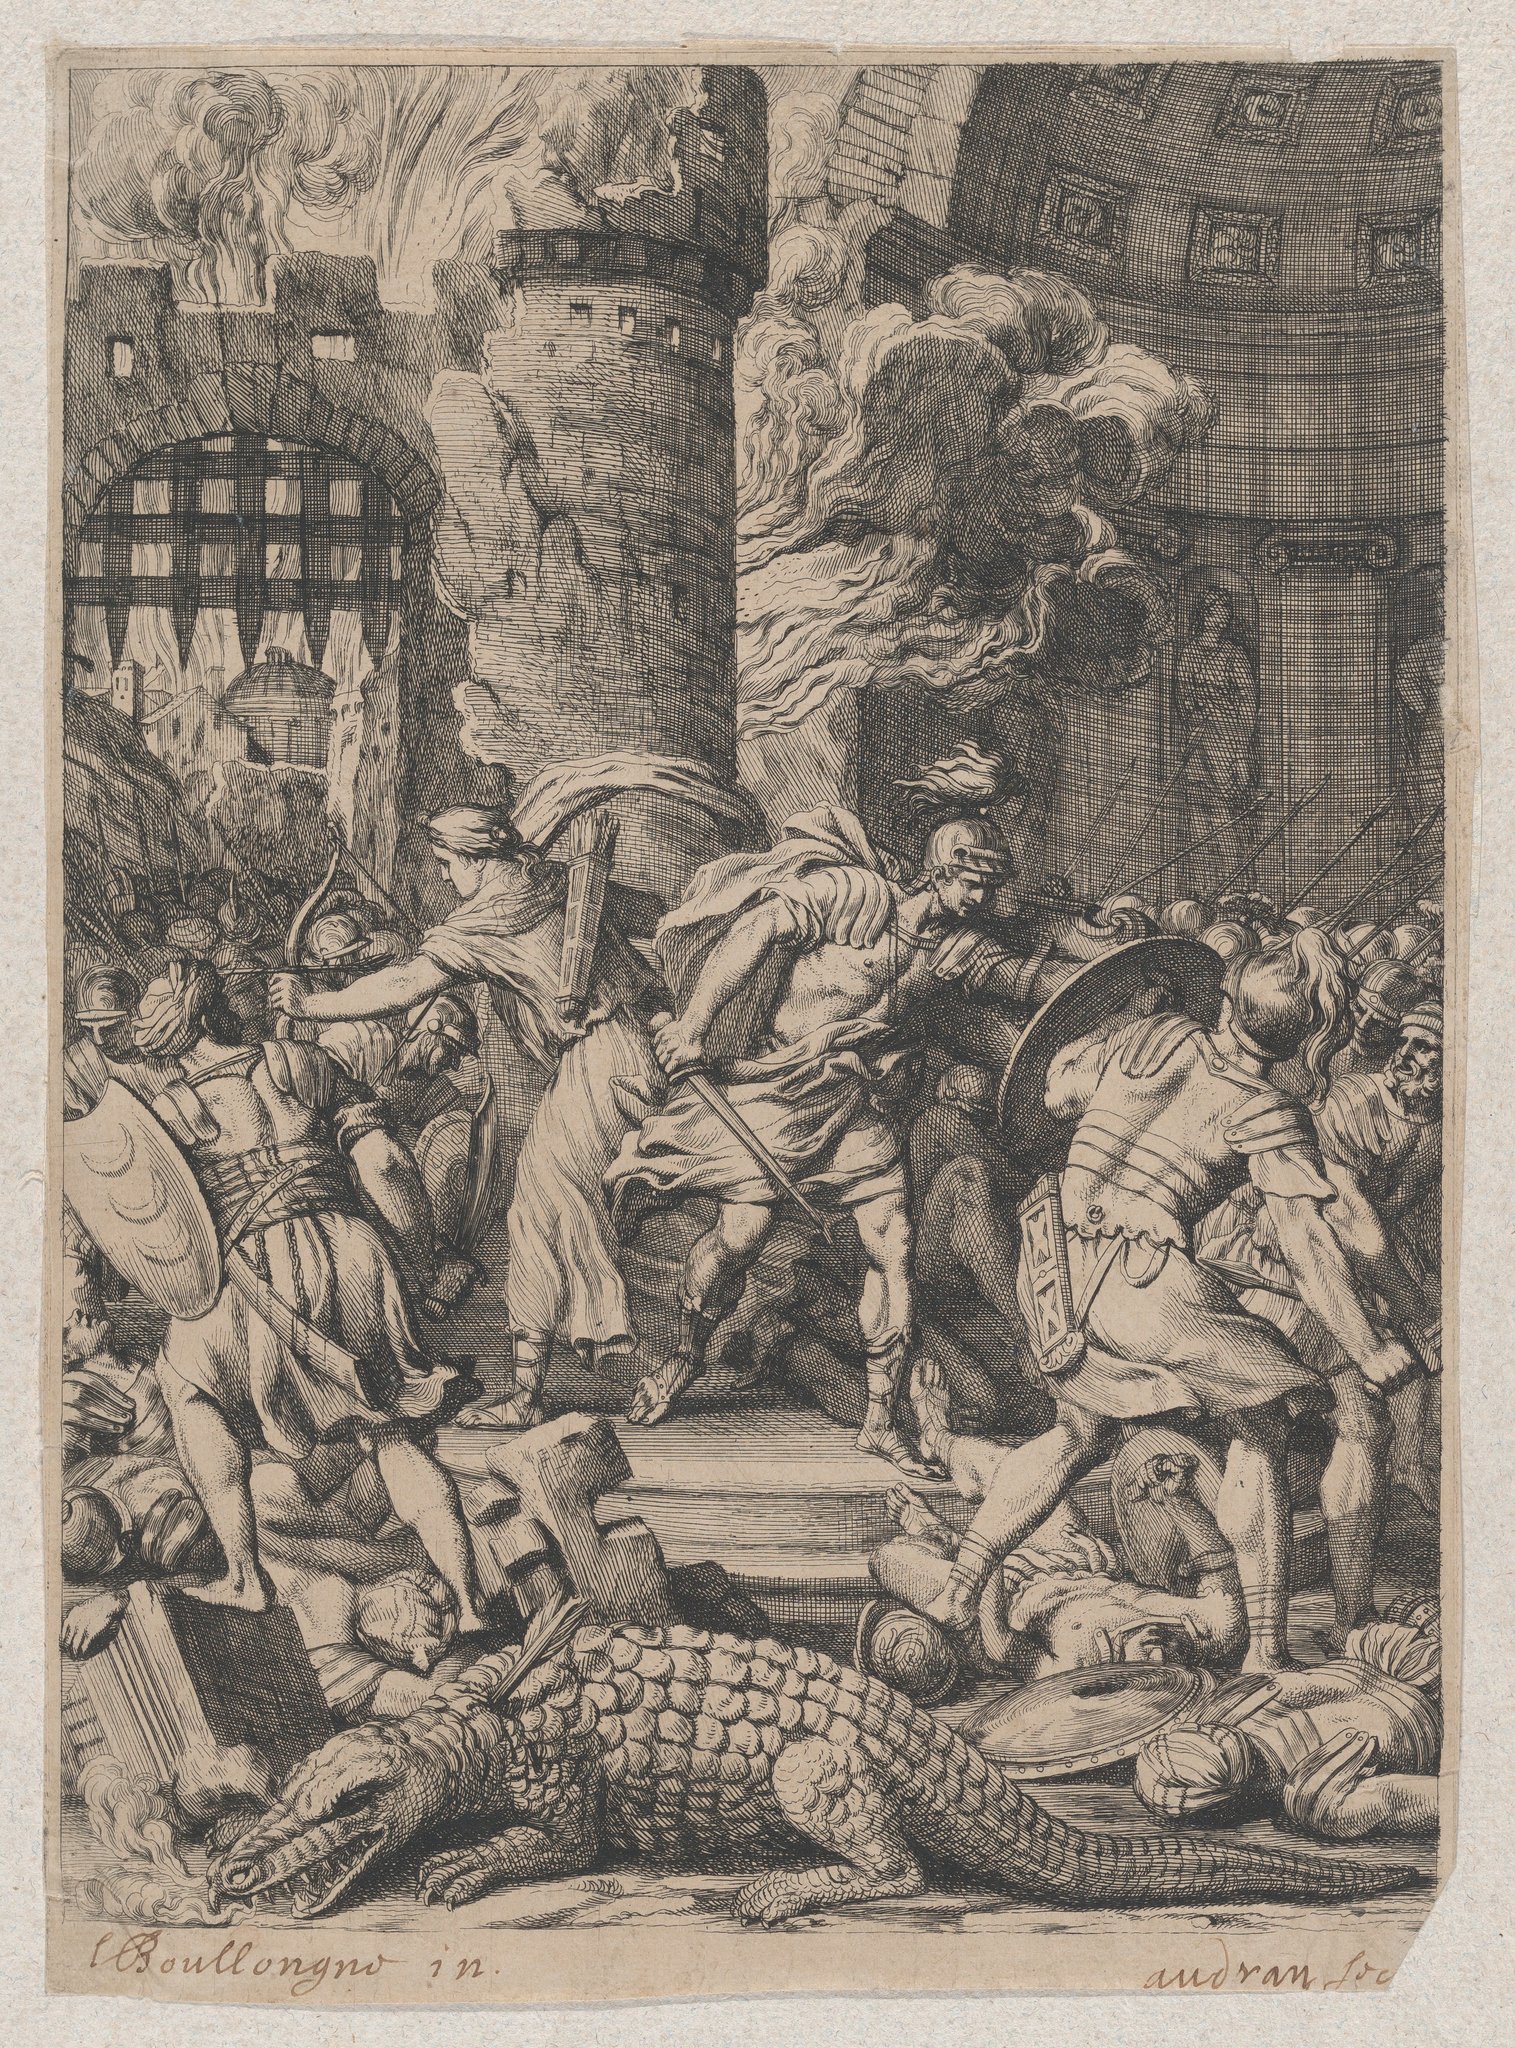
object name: print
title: Battle in a Burning City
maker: audran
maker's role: artist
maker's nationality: french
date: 1680-1756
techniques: engraving, etching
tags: battles,army,weapons,crocodiles,fire